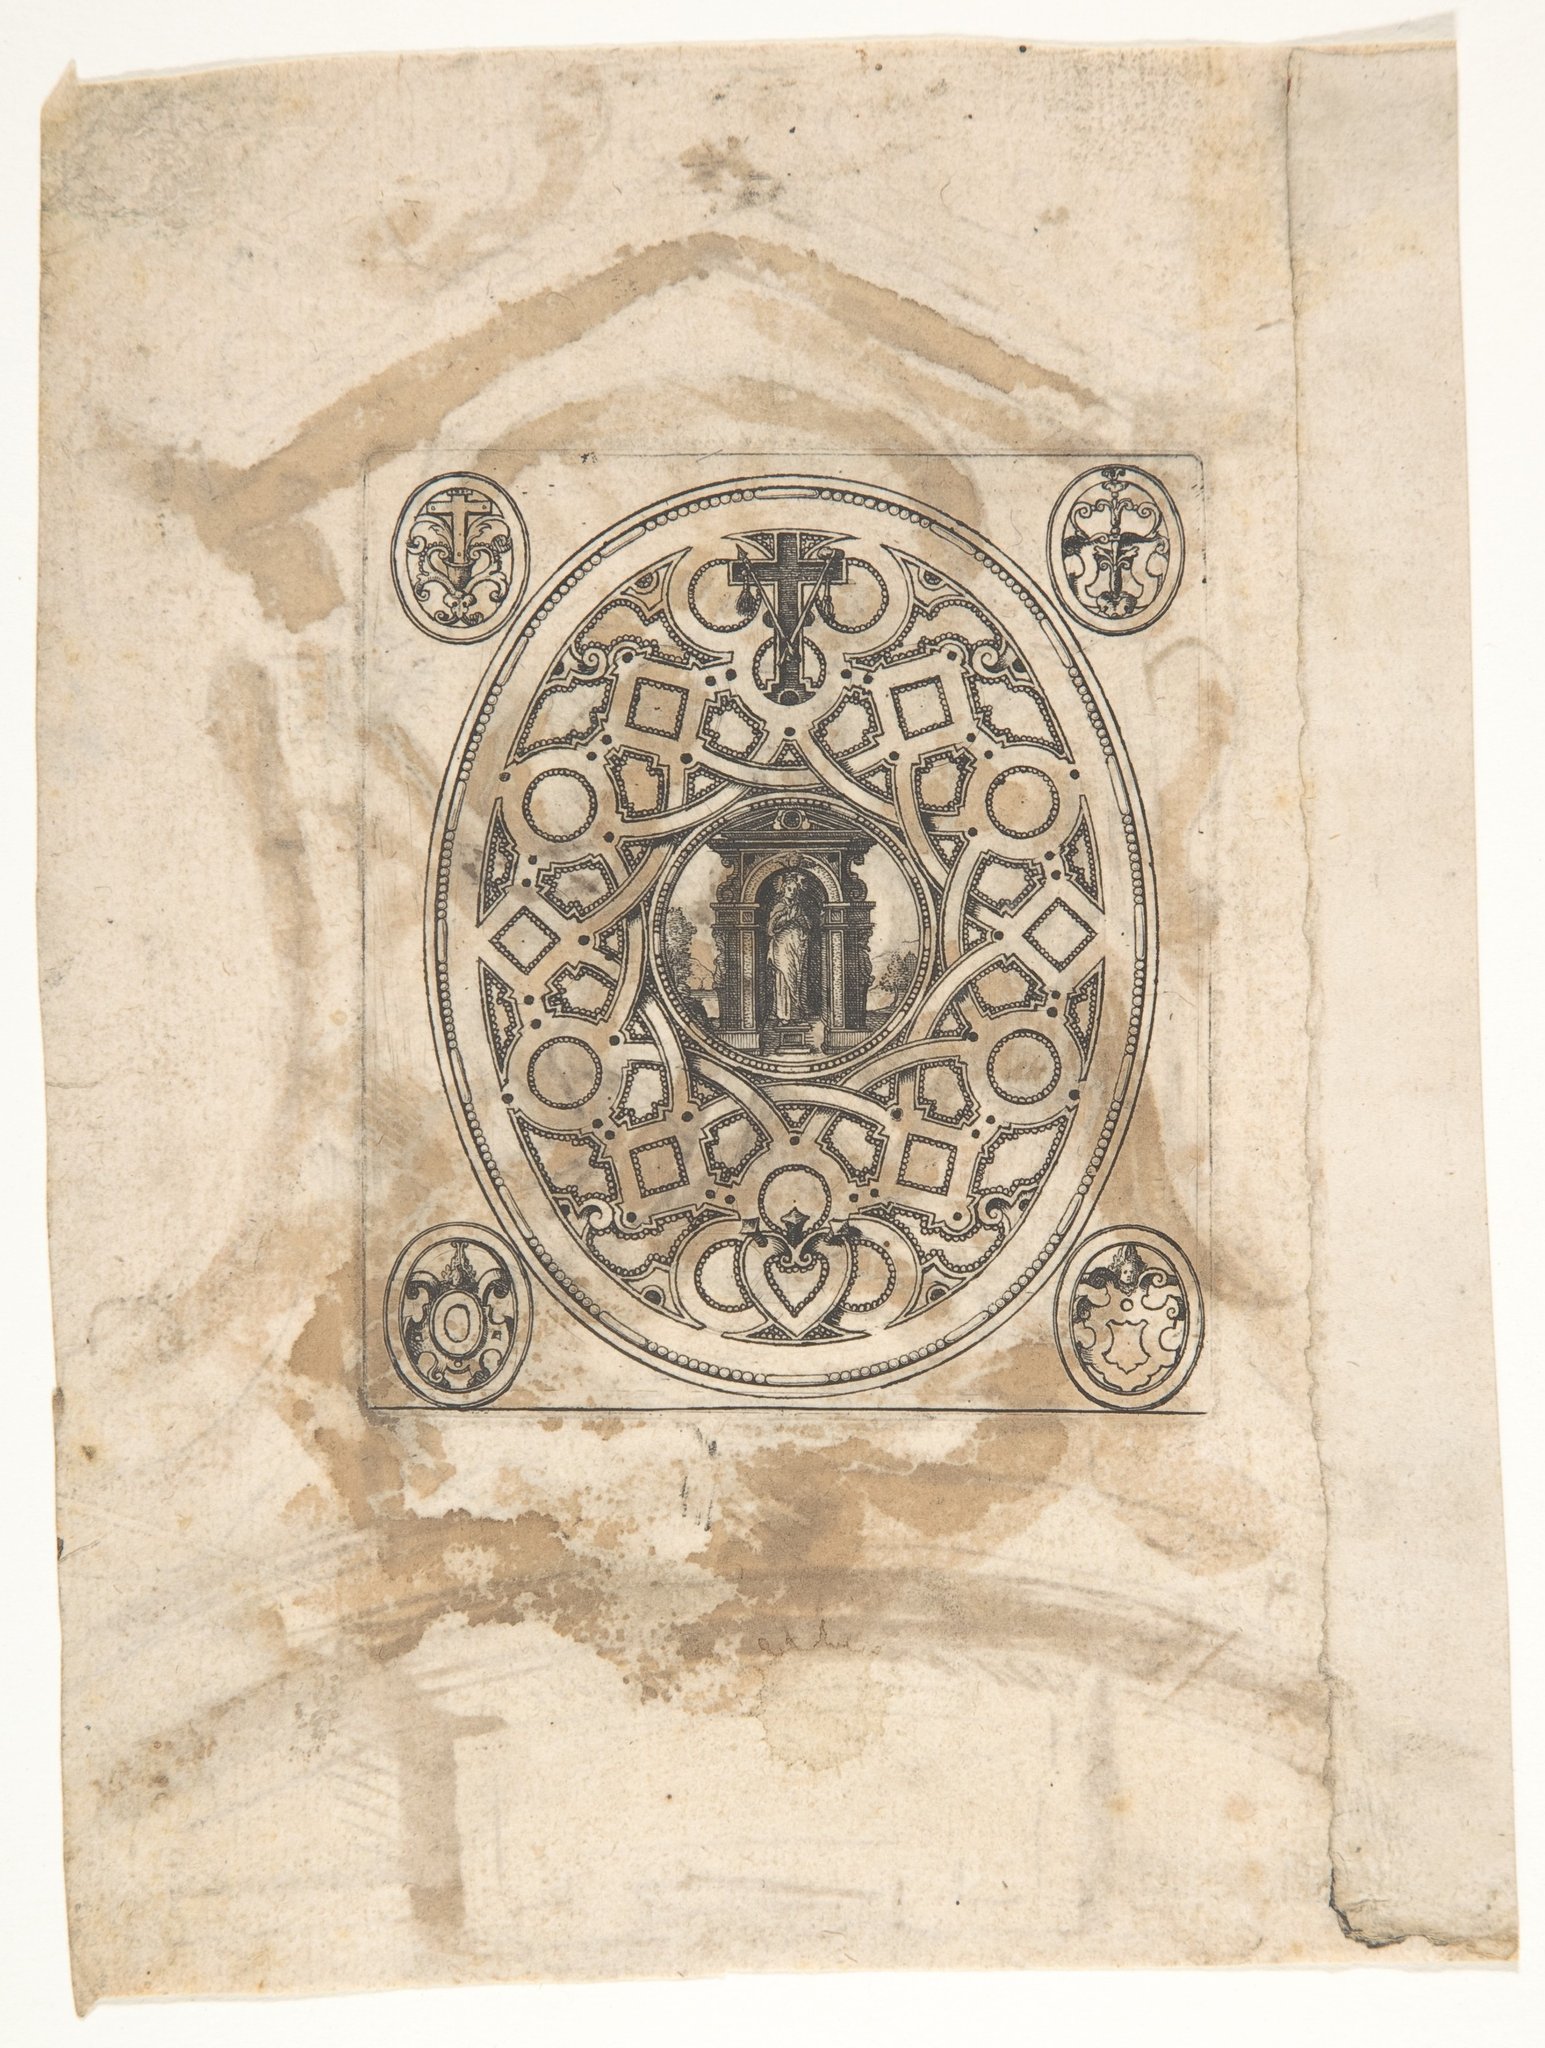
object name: print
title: The standing Virgin with an elaborate ornamental frame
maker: anonymous, netherlandish, 16th century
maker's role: artist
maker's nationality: netherlandish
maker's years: 1500-1600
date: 1601-1700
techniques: engraving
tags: ornament,virgin mary